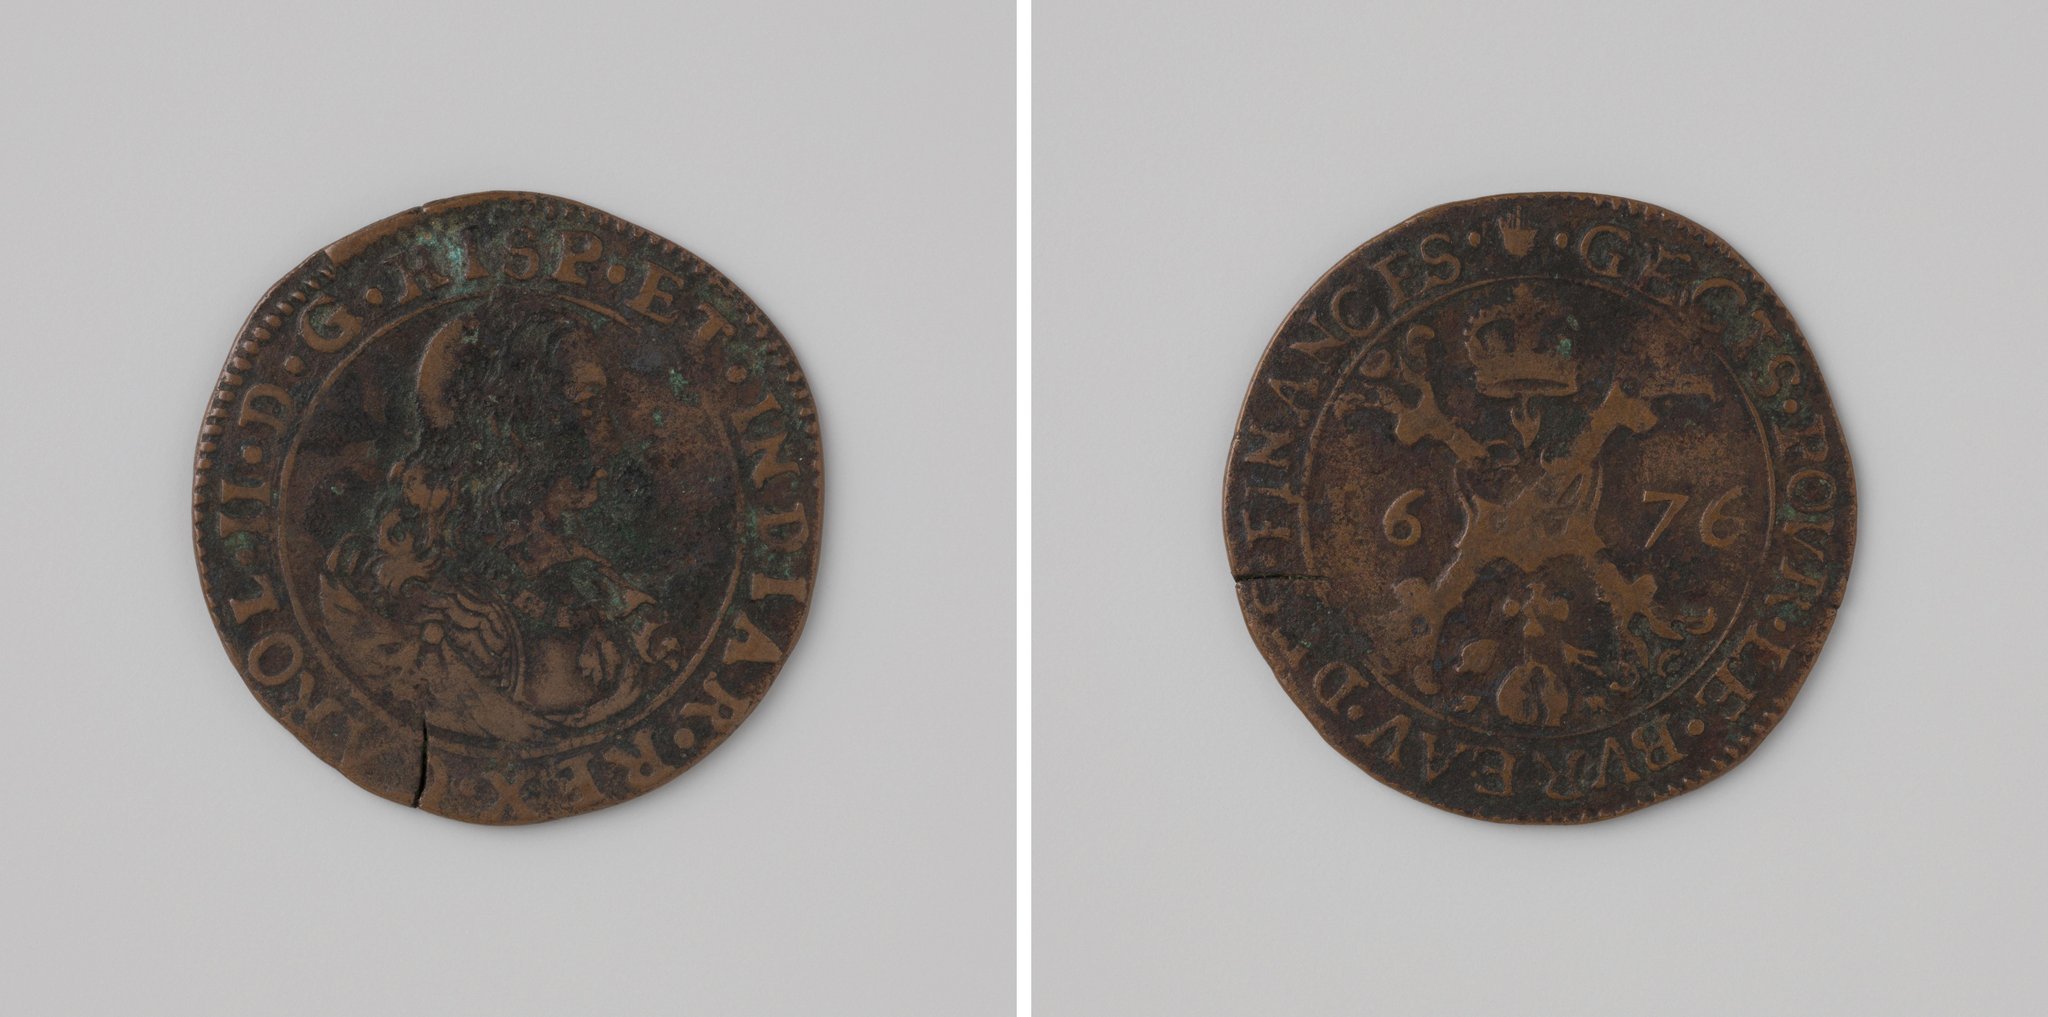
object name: jeton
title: Karel II, koning van Spanje, rekenpenning geslagen op last van de raad van Financiën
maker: Anonymous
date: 1676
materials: copper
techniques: striking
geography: antwerp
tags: karel ii (koning van spanje)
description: Koperen penning. Voorzijde: borststuk man binnen omschrift. Keerzijde: vuurslag onder kroon op Bourgondisch kruis tussen jaartal; daaronder: vuursteen, waar vonken uitschieten binnen omschrift